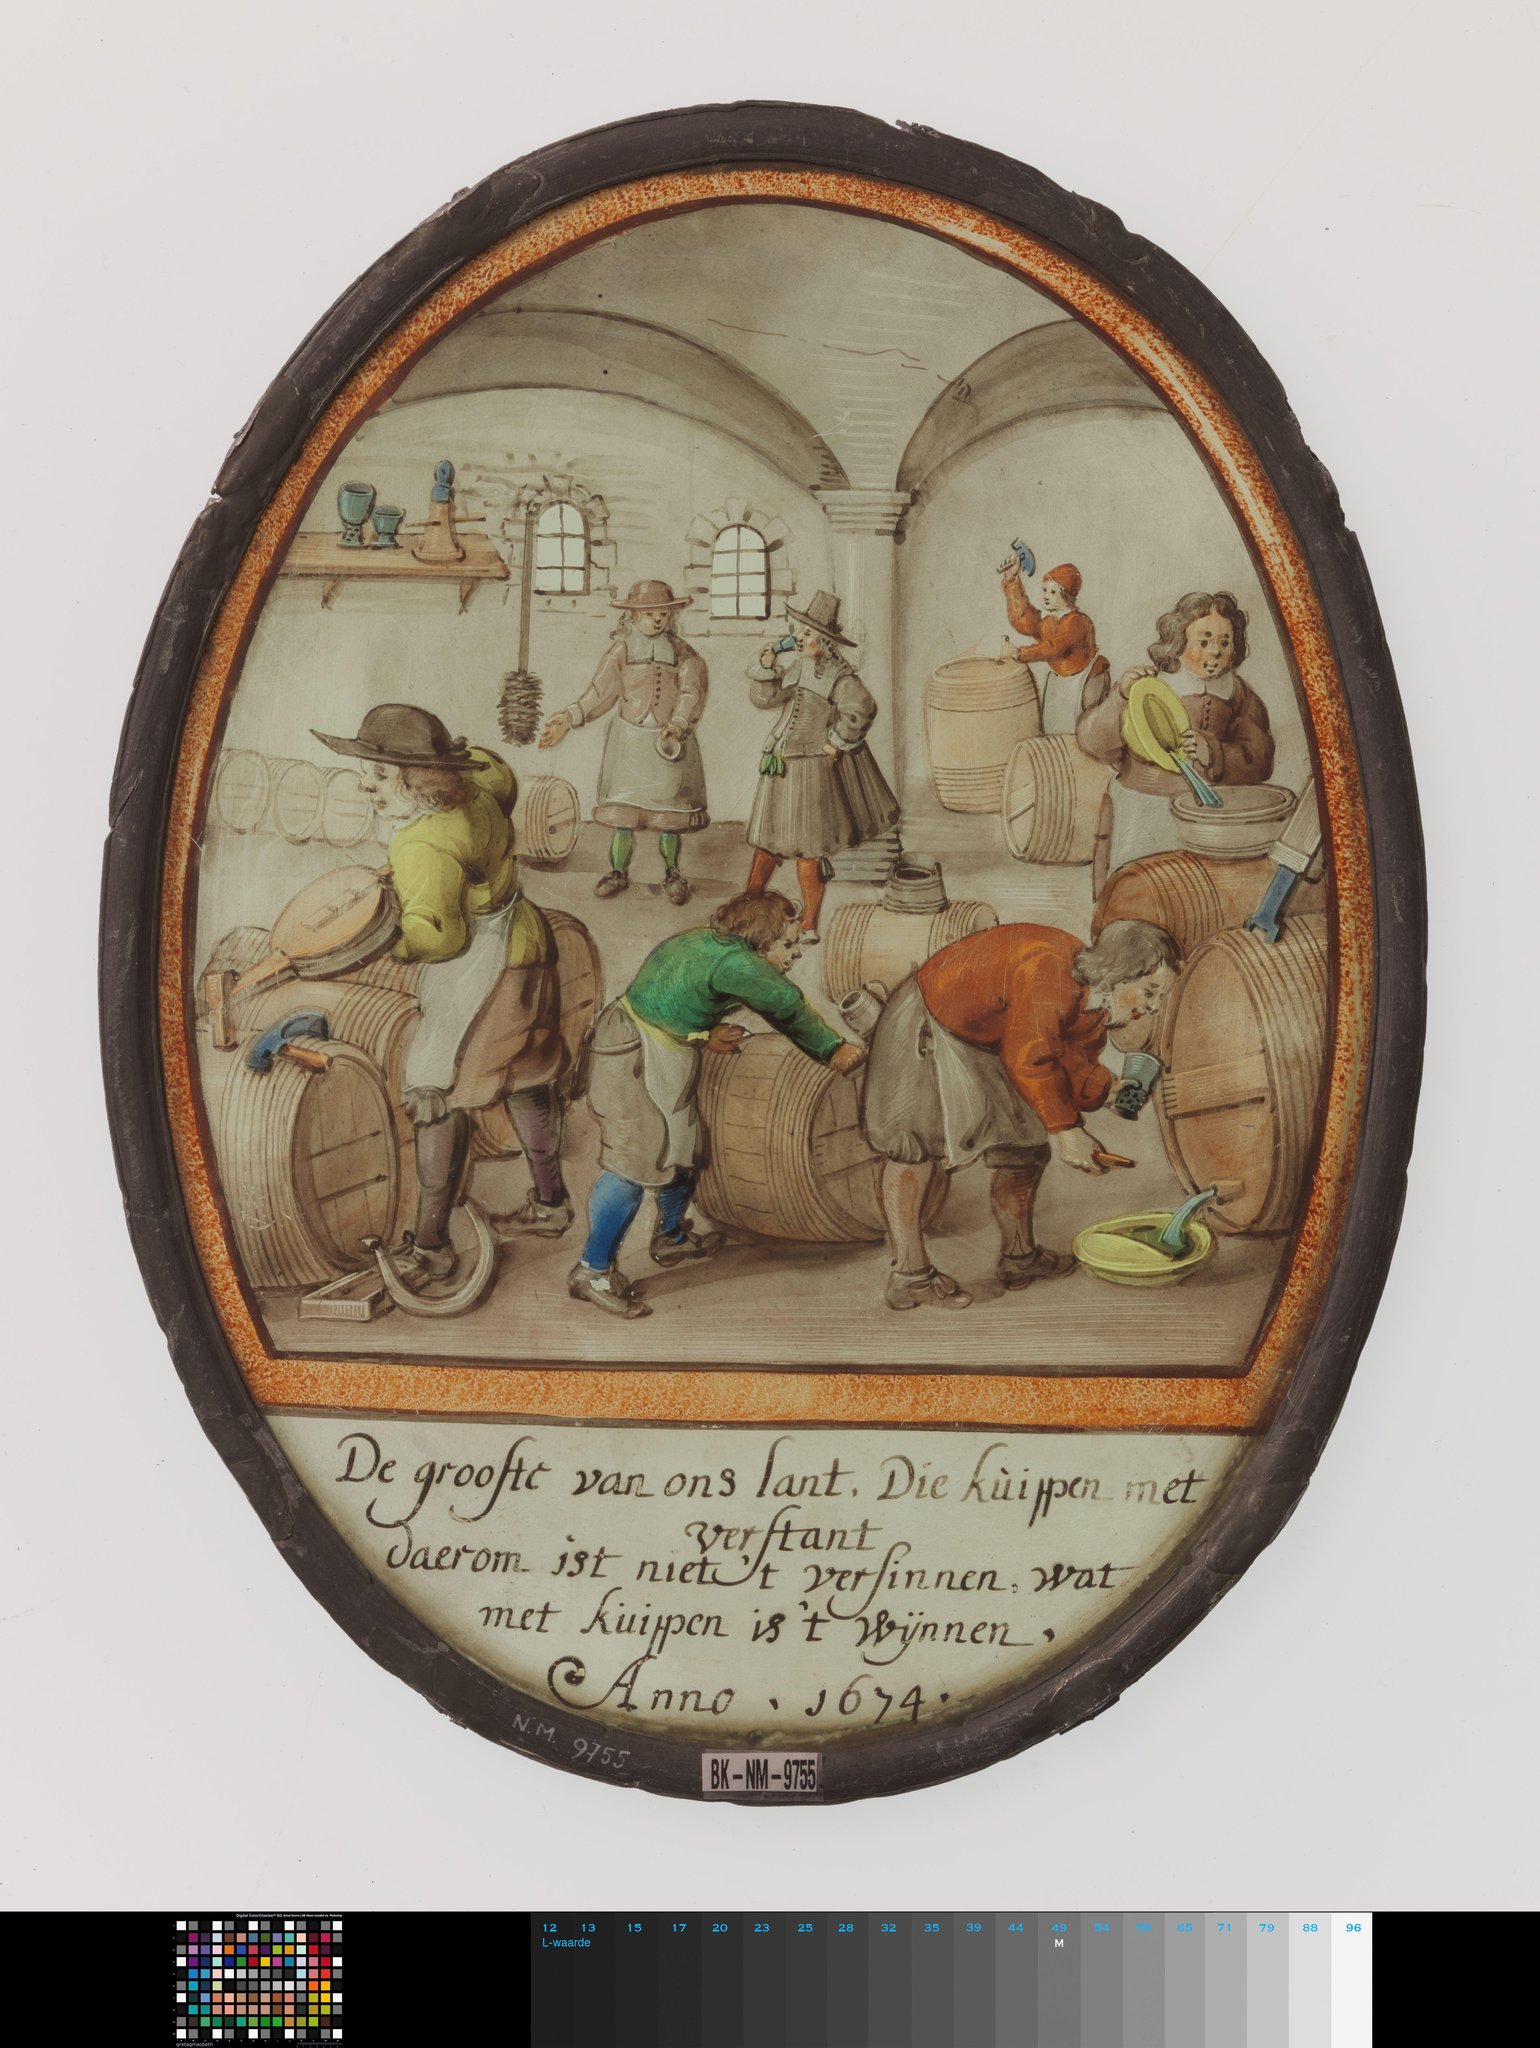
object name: light window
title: Ruit met voorstelling van het kuipen van wijn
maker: Anonymous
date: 1674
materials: glass, lead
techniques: leading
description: Een ovale ruit met gebrandschilderde voorstelling van het kuipen van wijn, met onderschrift.